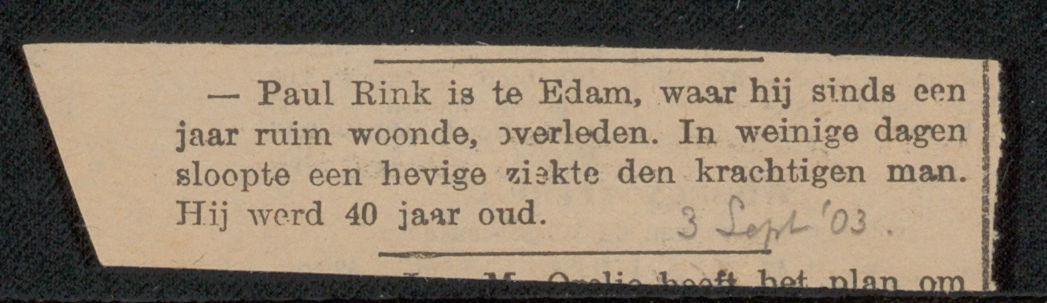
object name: newspaper clipping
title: Krantenknipsel uit archief Philip Zilcken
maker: Anonymous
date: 1903-1909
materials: paper, ink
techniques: printing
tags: paul rink, the hague, painter, draughtsman, philip zilcken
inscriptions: collector's mark: ‘RPK’